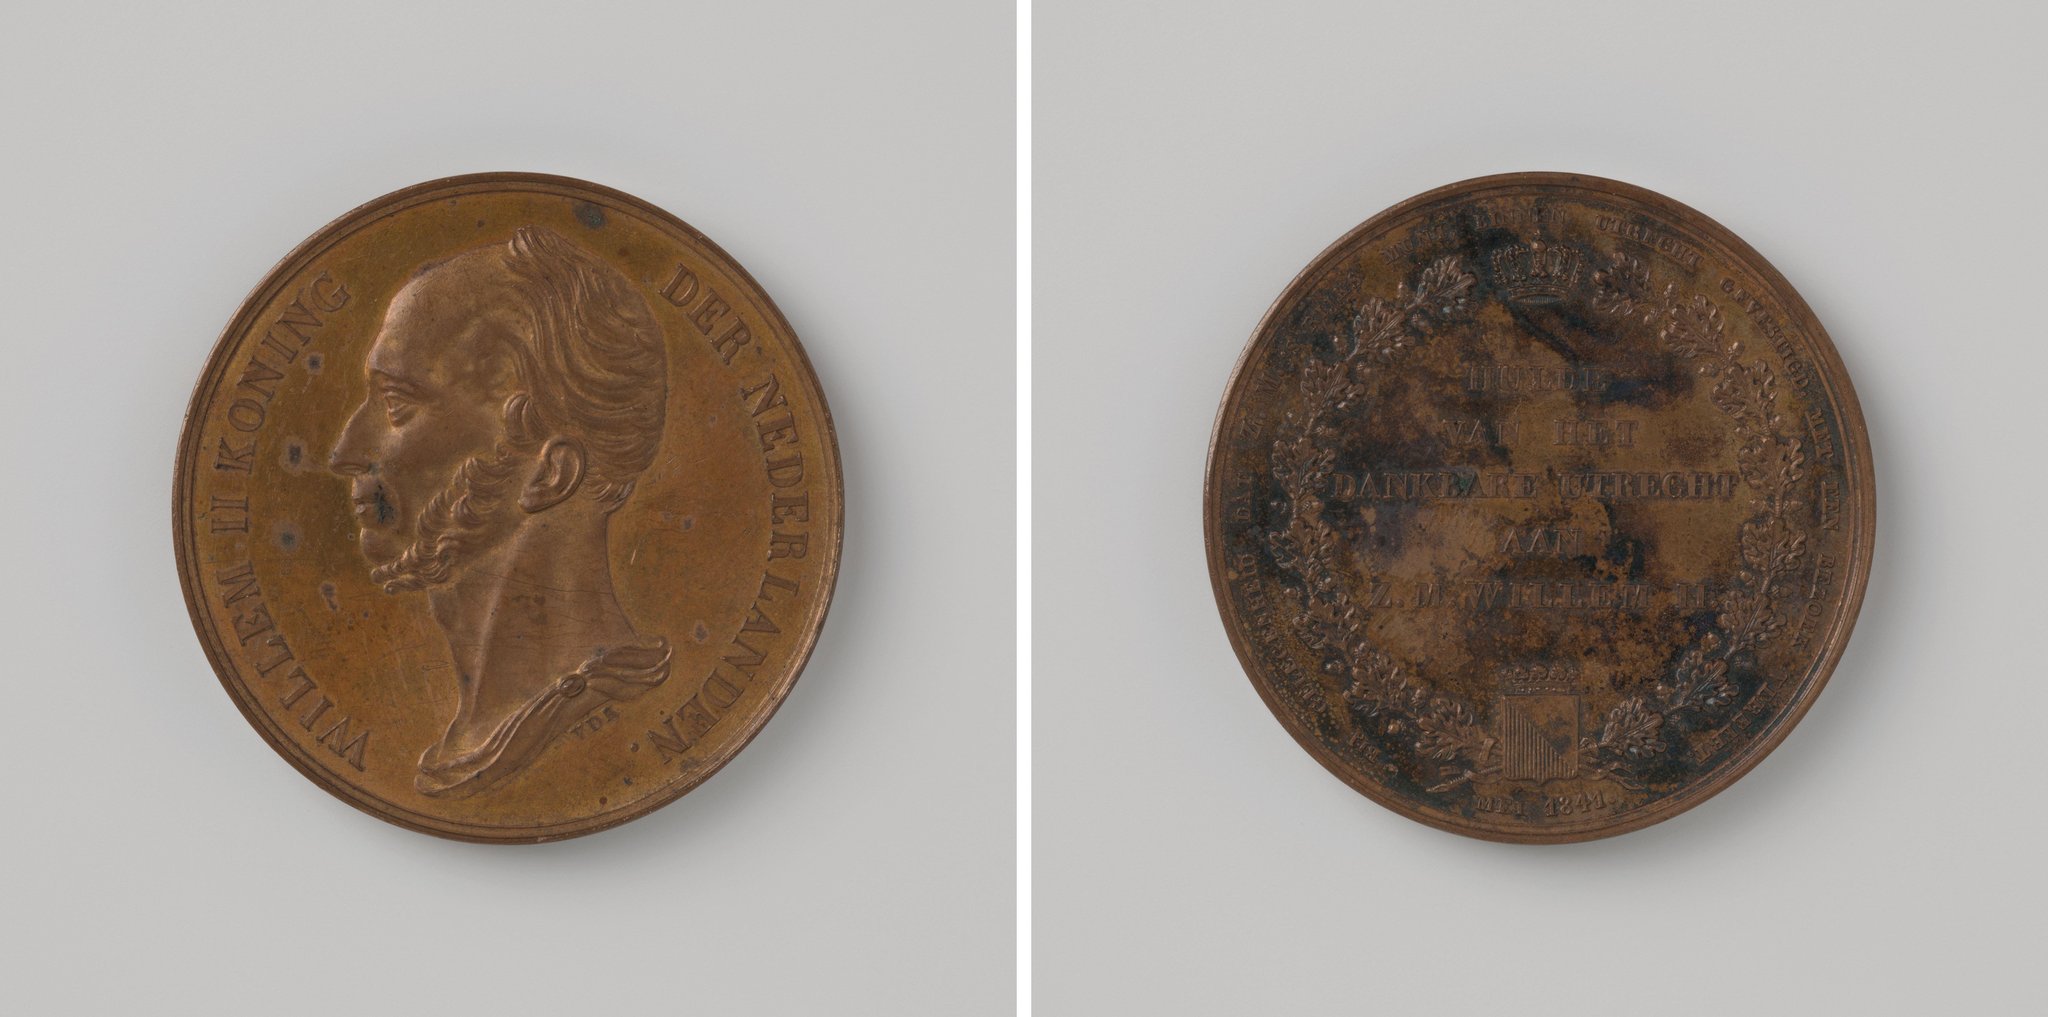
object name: history medal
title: Bezoek van Willem II aan 's Rijks Munt te Utrecht 1841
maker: david van der kellen (1804-1879)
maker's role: die cutter, draughtsman, print maker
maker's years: 1804-1879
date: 1840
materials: bronze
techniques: striking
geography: utrecht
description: Bronzen penning, op de voorzijde het portret van Willem II naar links met omschrift, op de keerzijde vijf regels tekst onder een kleine kroon tussen samengestrikte eikentakken, waarop onderaan aan klein Utrechts wapenschild, met omschrift.